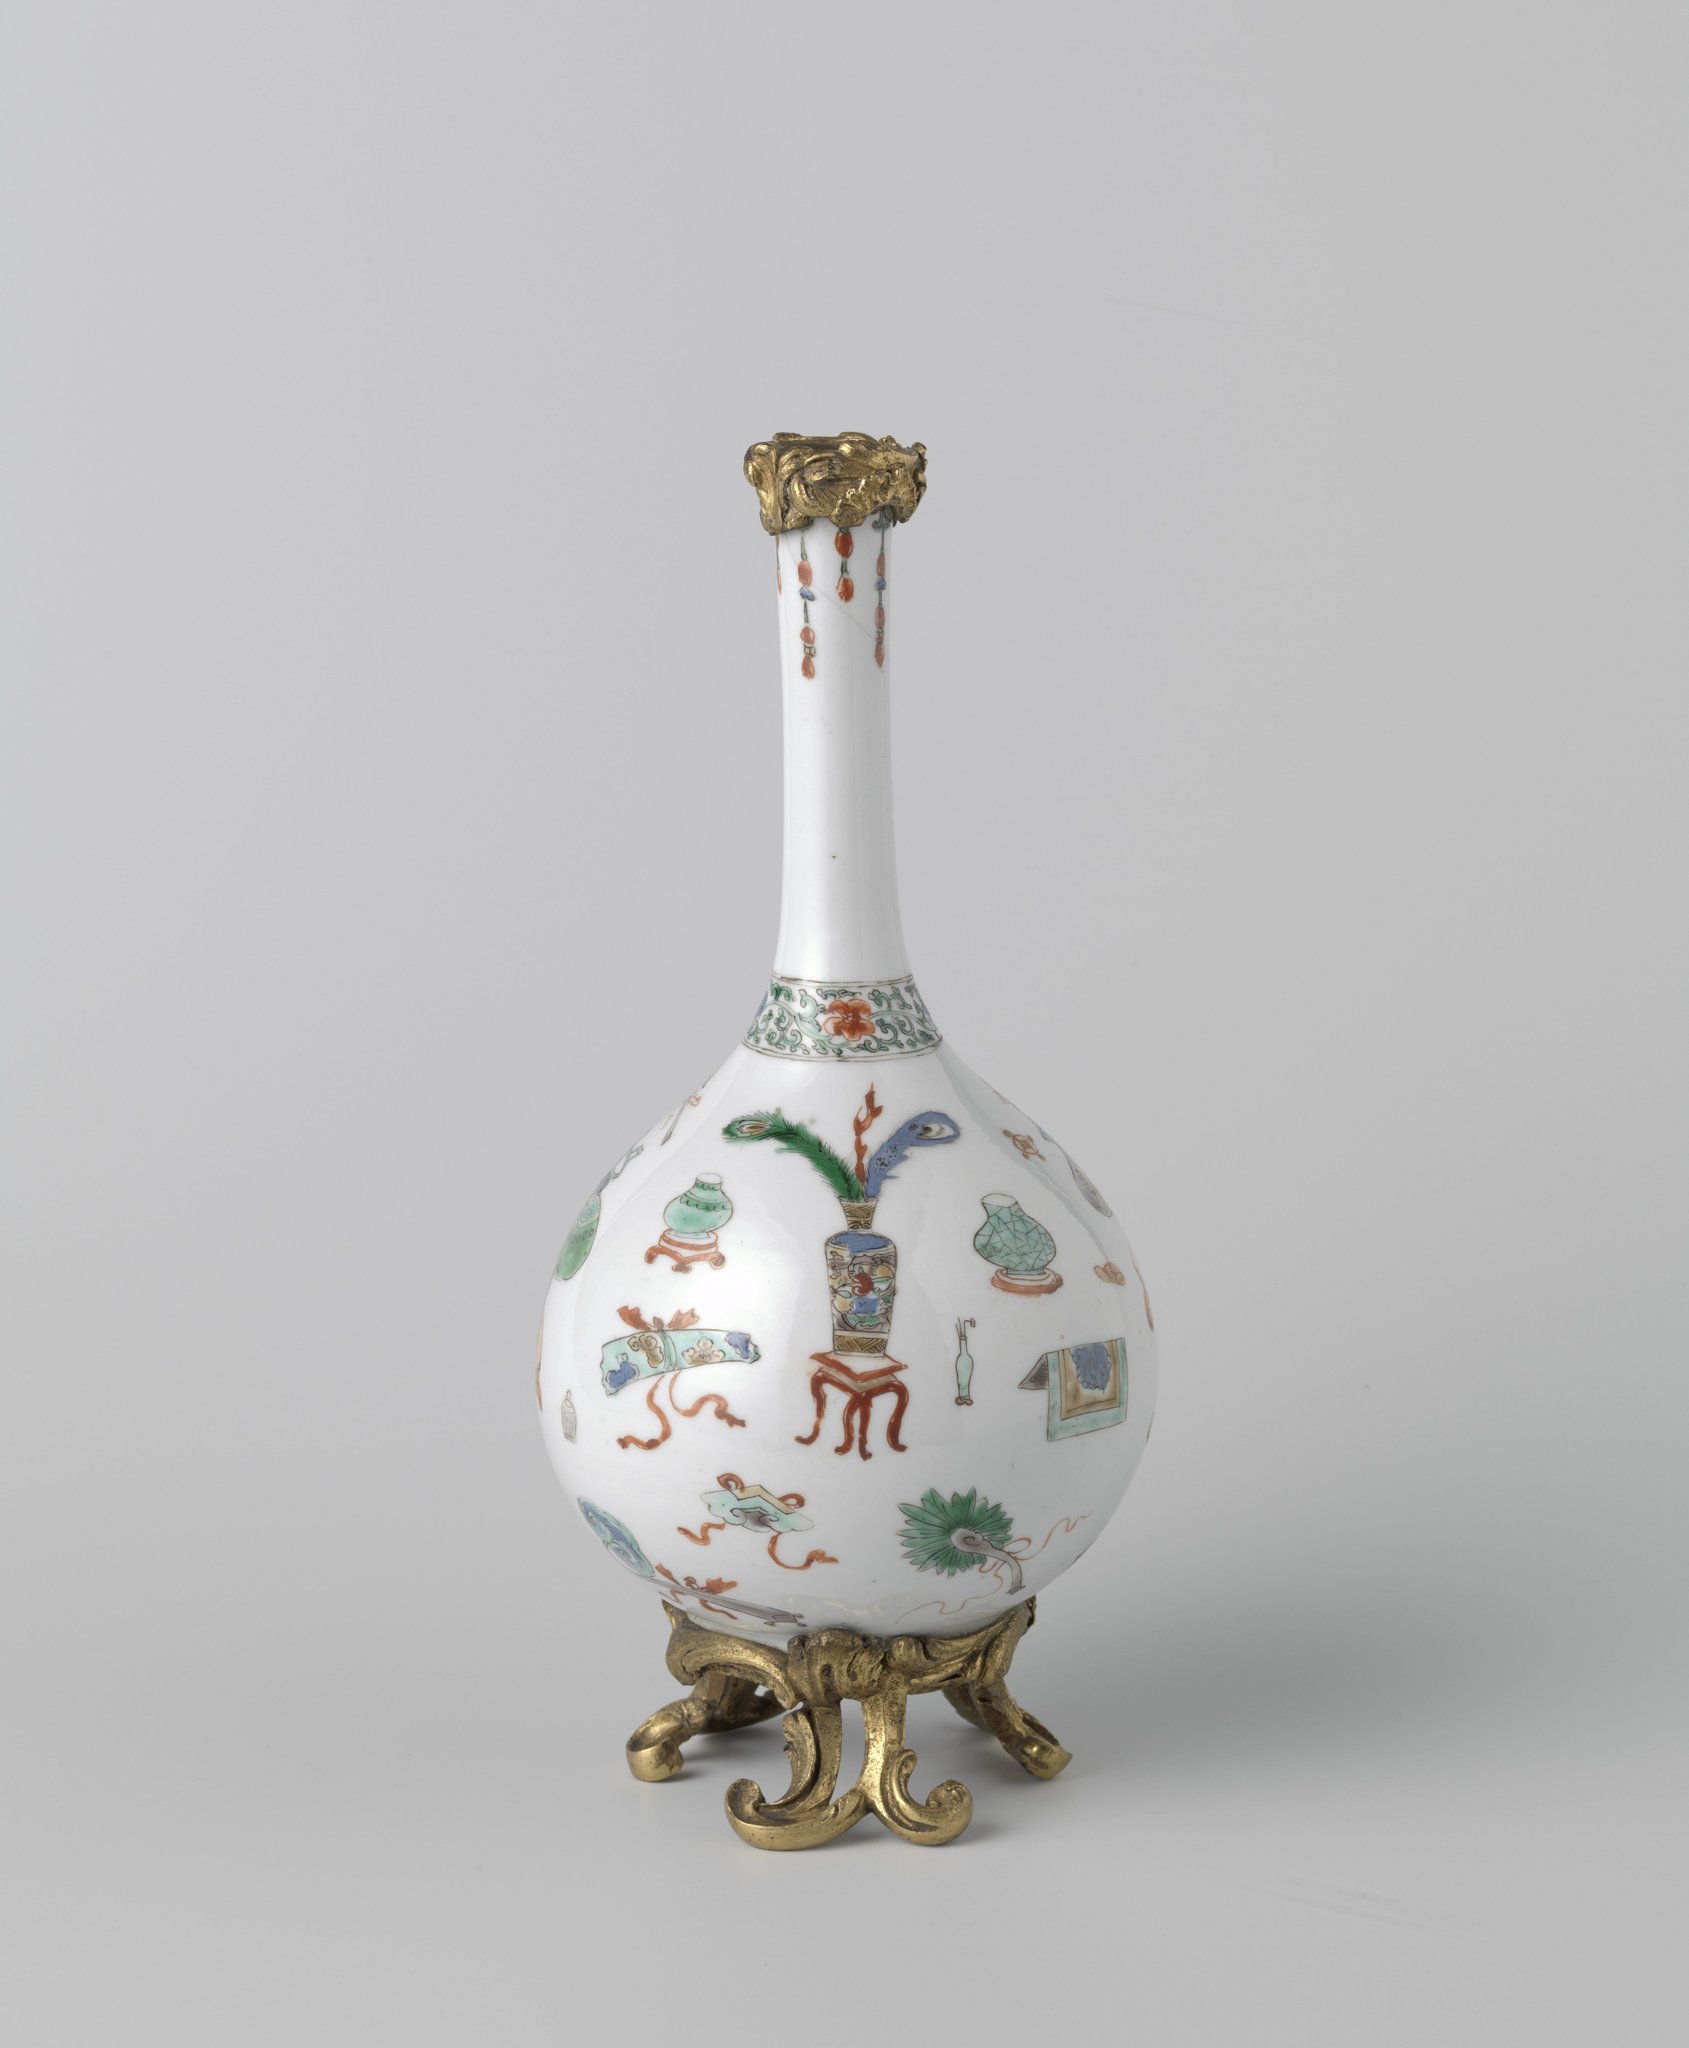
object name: bottle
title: Bottle vase with antiquities, precious object and auspicious objects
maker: Anonymous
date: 1700-1724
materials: bronze, glaze, gold, paint, porcelain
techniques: firing, gilding, turning, vitrification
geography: china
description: Flesvormige vaas van porselein met een bolvormig lichaam en een lange, smalle nek, beschilderd op het glazuur in blauw, rood, groen, geel, aubergine, zwart en goud. Op de buik antiquiteiten (driepoot. boeken, bloemenvaas, rollen, wierookbrander, qin, ruyi-scepter, vaas met pauwenveren, lotus-scepter), kostbaarheden (muzieksteen, artemisiablad) en geluksvoorwerpen (schelp). Op de schouder een band met bloemranken; de rand met een band afhangende kwasten. De fles is gevat in een bronzen Lodewijk XV montuur. Famille verte.